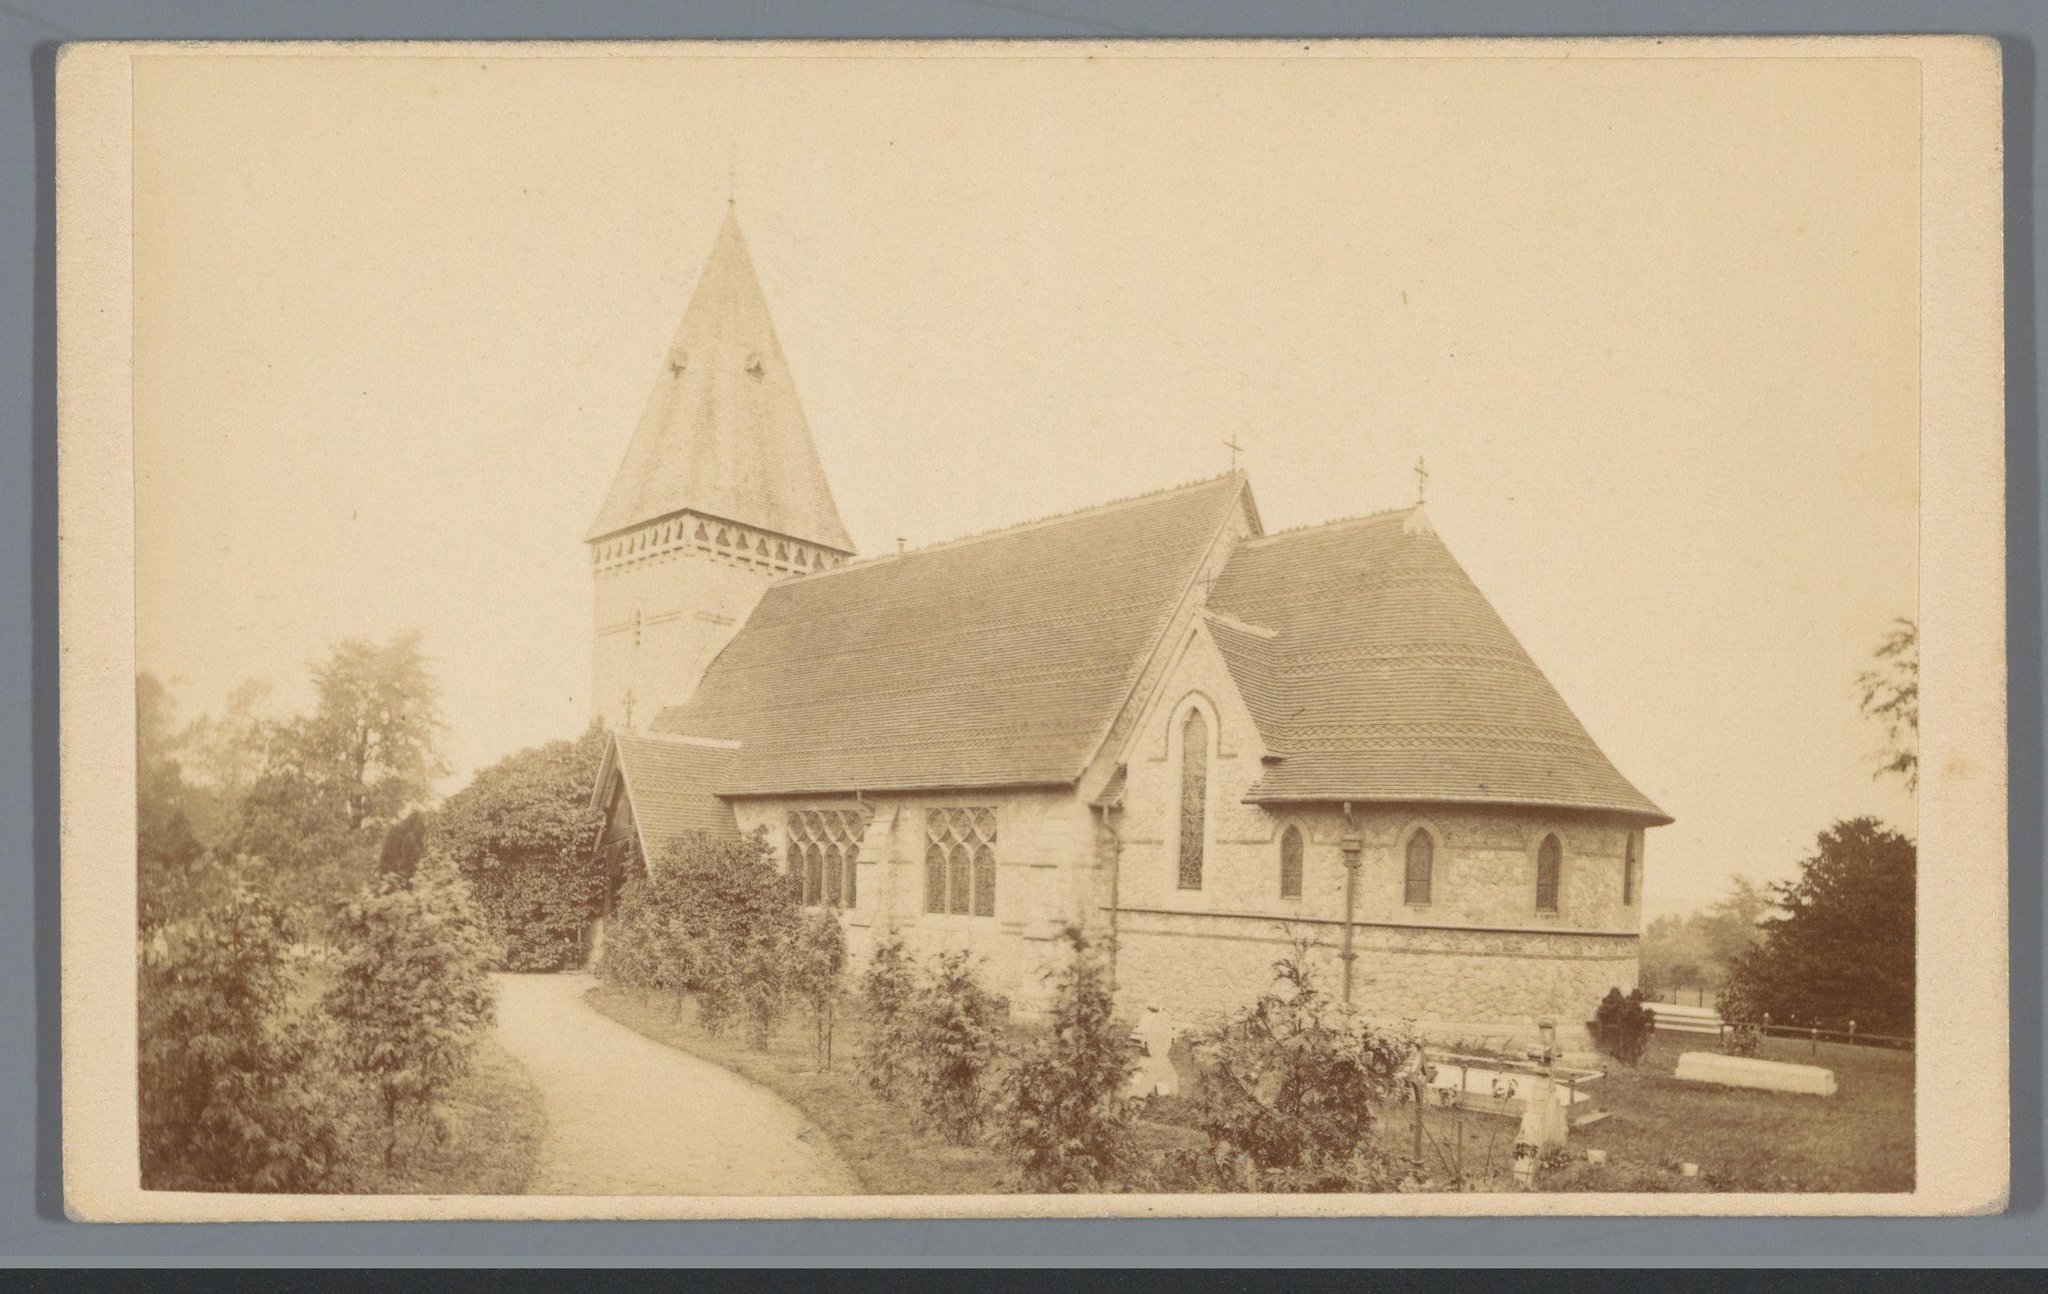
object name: photograph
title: Gezicht op een kerk, mogelijk in Richmond Hill, Surrey, Engeland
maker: alfred seeley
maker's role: fotograaf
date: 1873-1879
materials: cardboard, paper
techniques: albumen print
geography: richmond hill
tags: non-roman catholic episcopal churches, e.g. anglicans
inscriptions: address: ‘Onslow Road/ Richmond Hill/ Surrey’, retailer's mark: ‘THE DARTFORD/ Stationary Warehouse,/ DUNKIN & SON,/ BOOKSELLERS & STATIONERS,/ 13, HIGH STREET,/ Established 1831.’, inscription: ‘VIEWS AND GROUPS PHOTOGRAPHED/ IN ANY PART OF THE COUNTRY/ Marion, hap. Paris.’